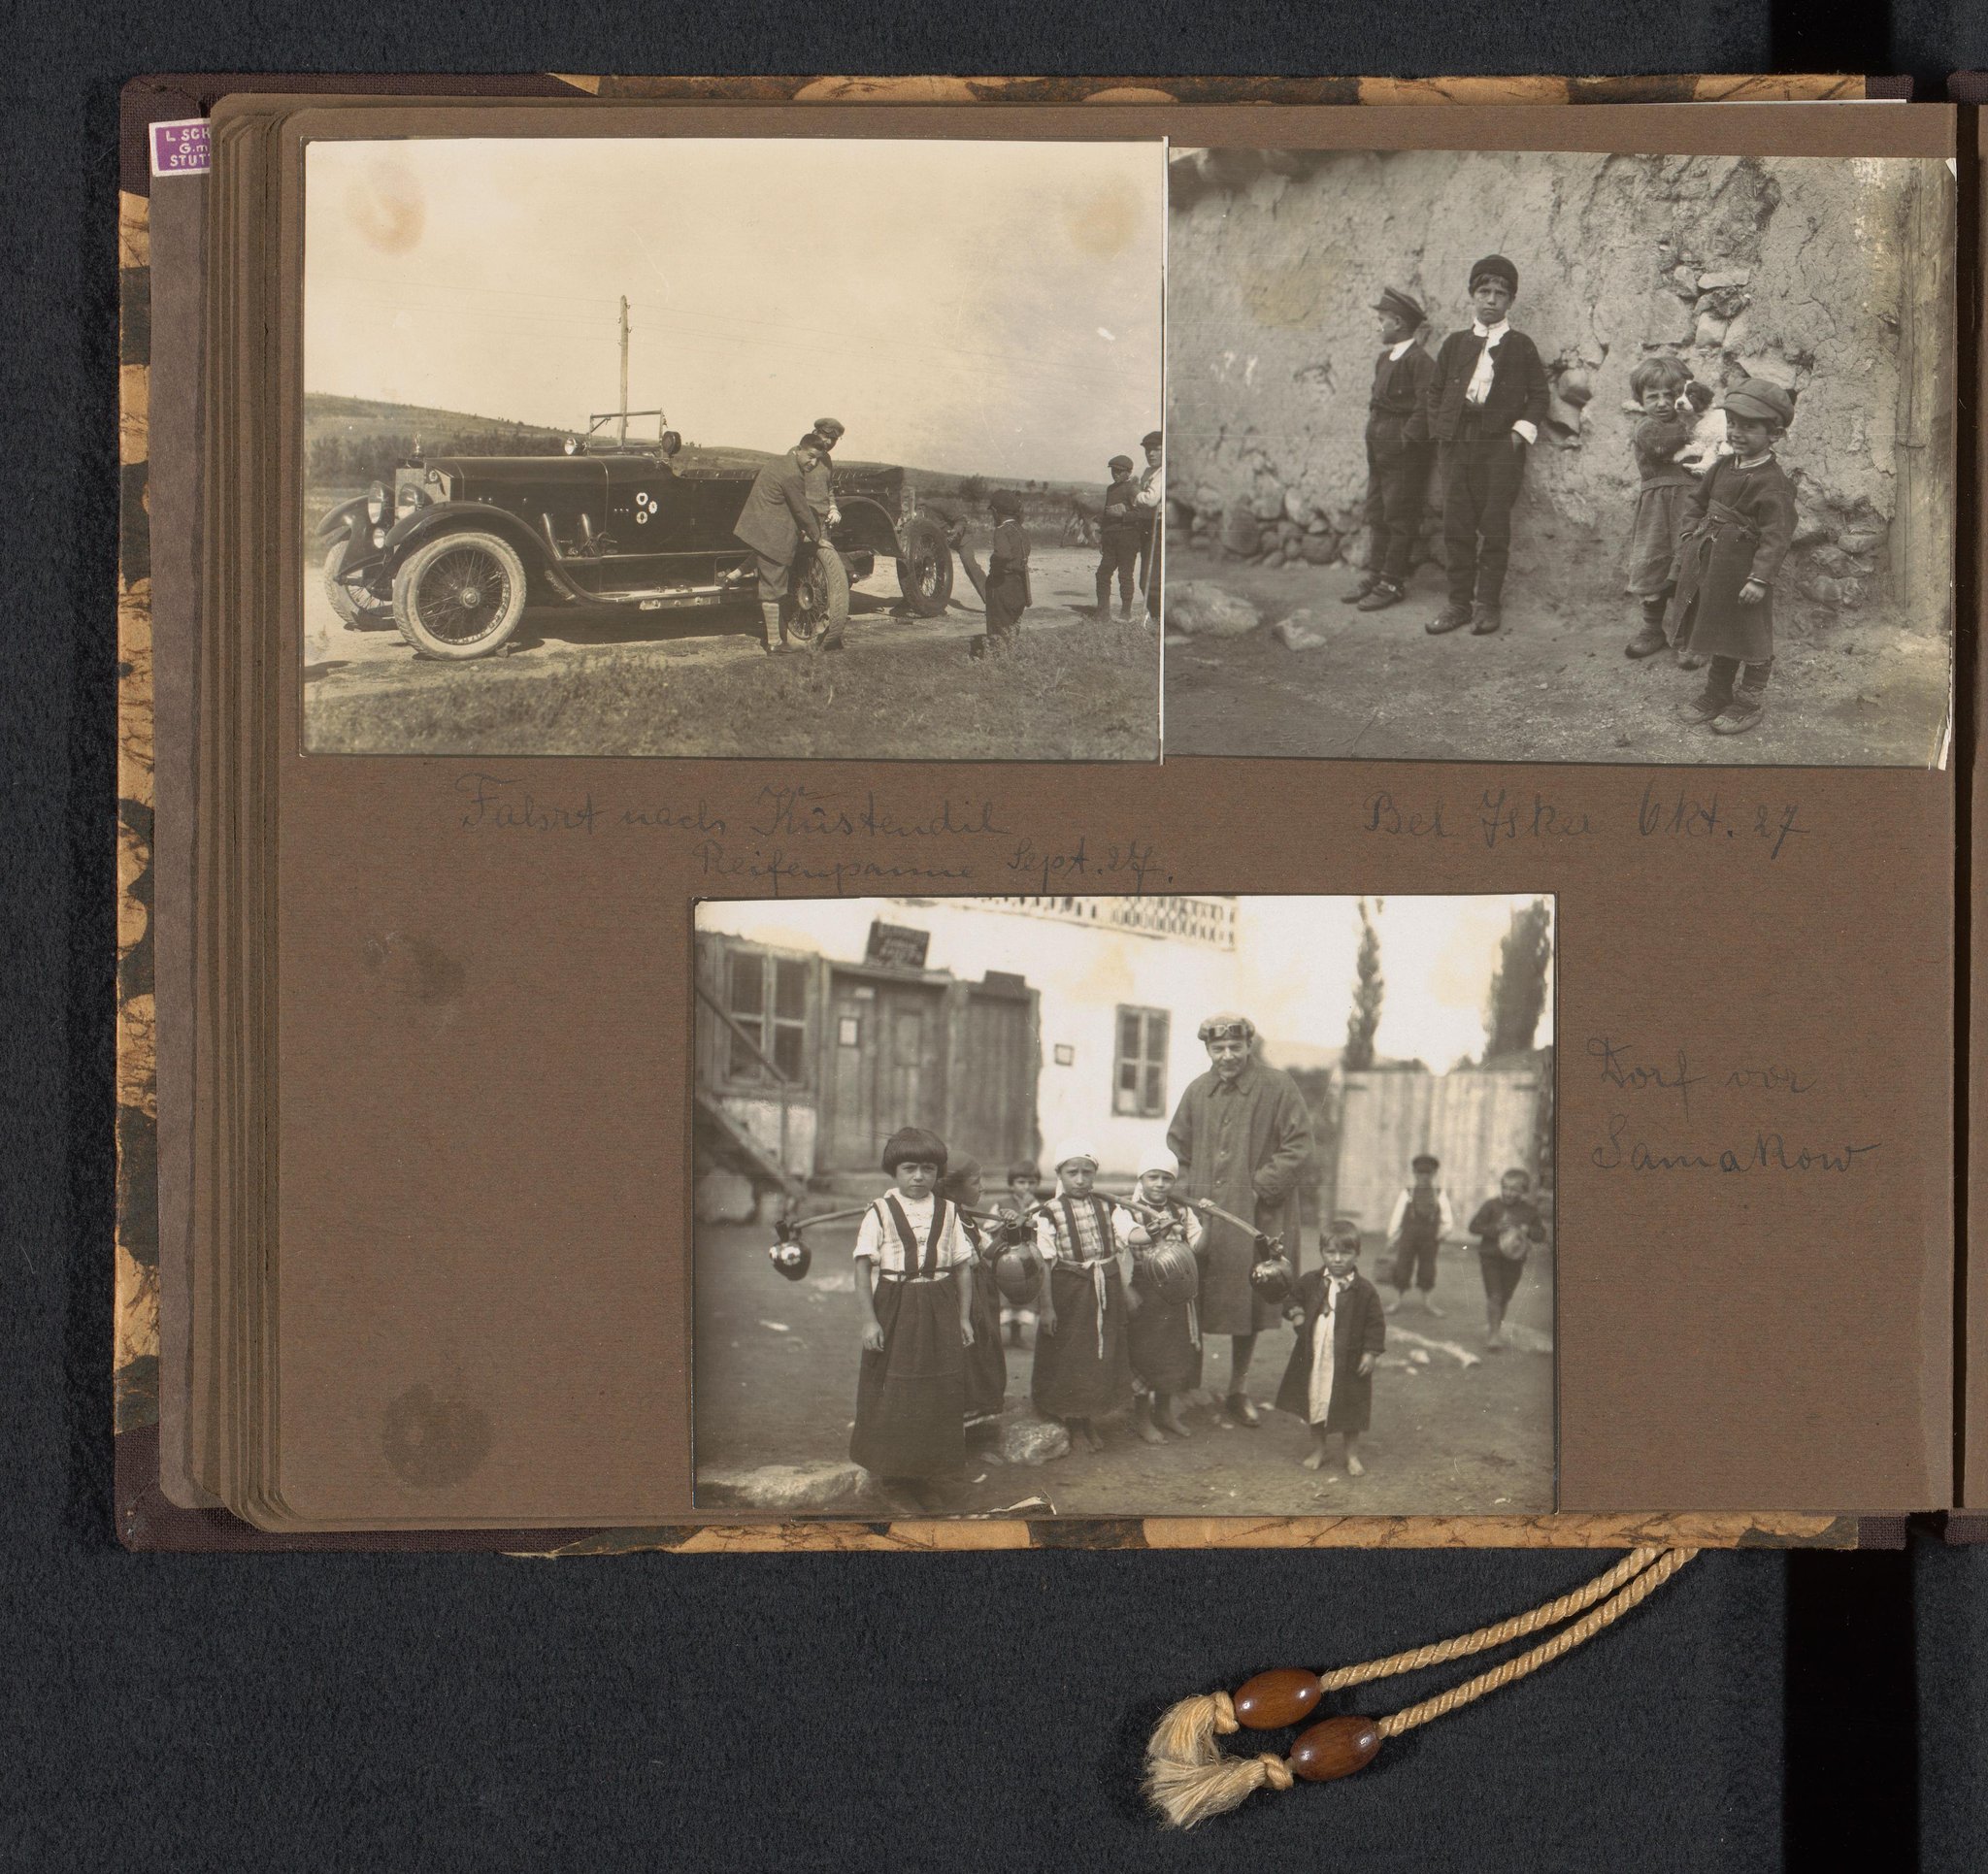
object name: album leaf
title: Bulgaarse kinderen en volwassenen in een Bulgaars dorp tijdens een rondreis van Else Wachenheimer-Moos en haar echtgenoot Eugen Wachenheimer, september-oktober 1927, Bulgarije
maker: else wachenheimer-moos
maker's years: 1895-1944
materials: paper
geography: bulgaria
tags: bulgarije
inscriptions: inscription: ‘Fahrt nach Küstendil Bel Isker Okt. 27 Reifenpanne Sept. 27’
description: Albumblad bevat drie foto's. Zonder personen gerelateerd aan de familie Wachenheimer. Afkomstig uit album half formaat, kartonomslag met koordbinding en lichte veelvormige vormen op voorzijde.